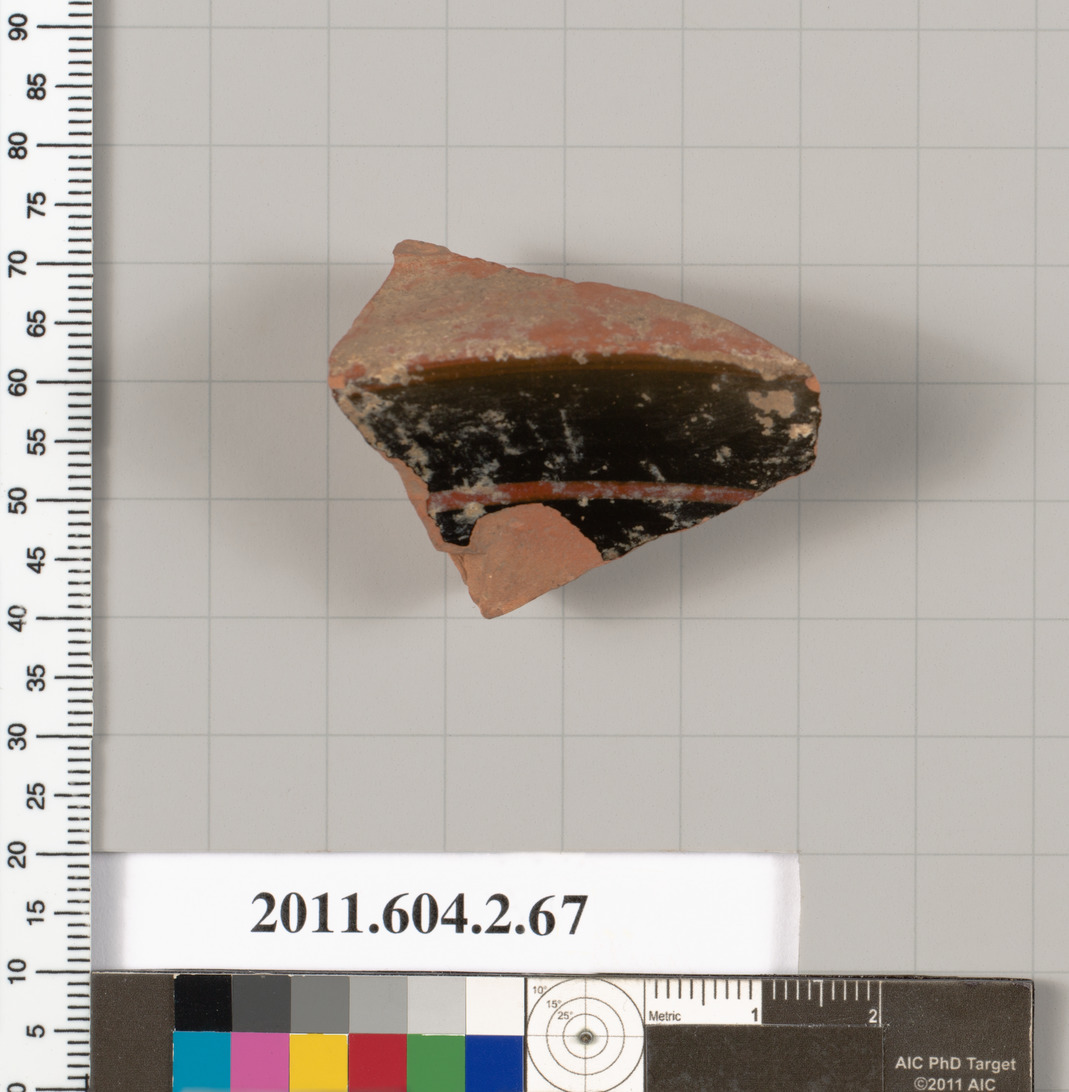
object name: amphora fragment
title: Terracotta fragment of an amphora (jar)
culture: greek, attic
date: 534-468 BCE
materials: terracotta